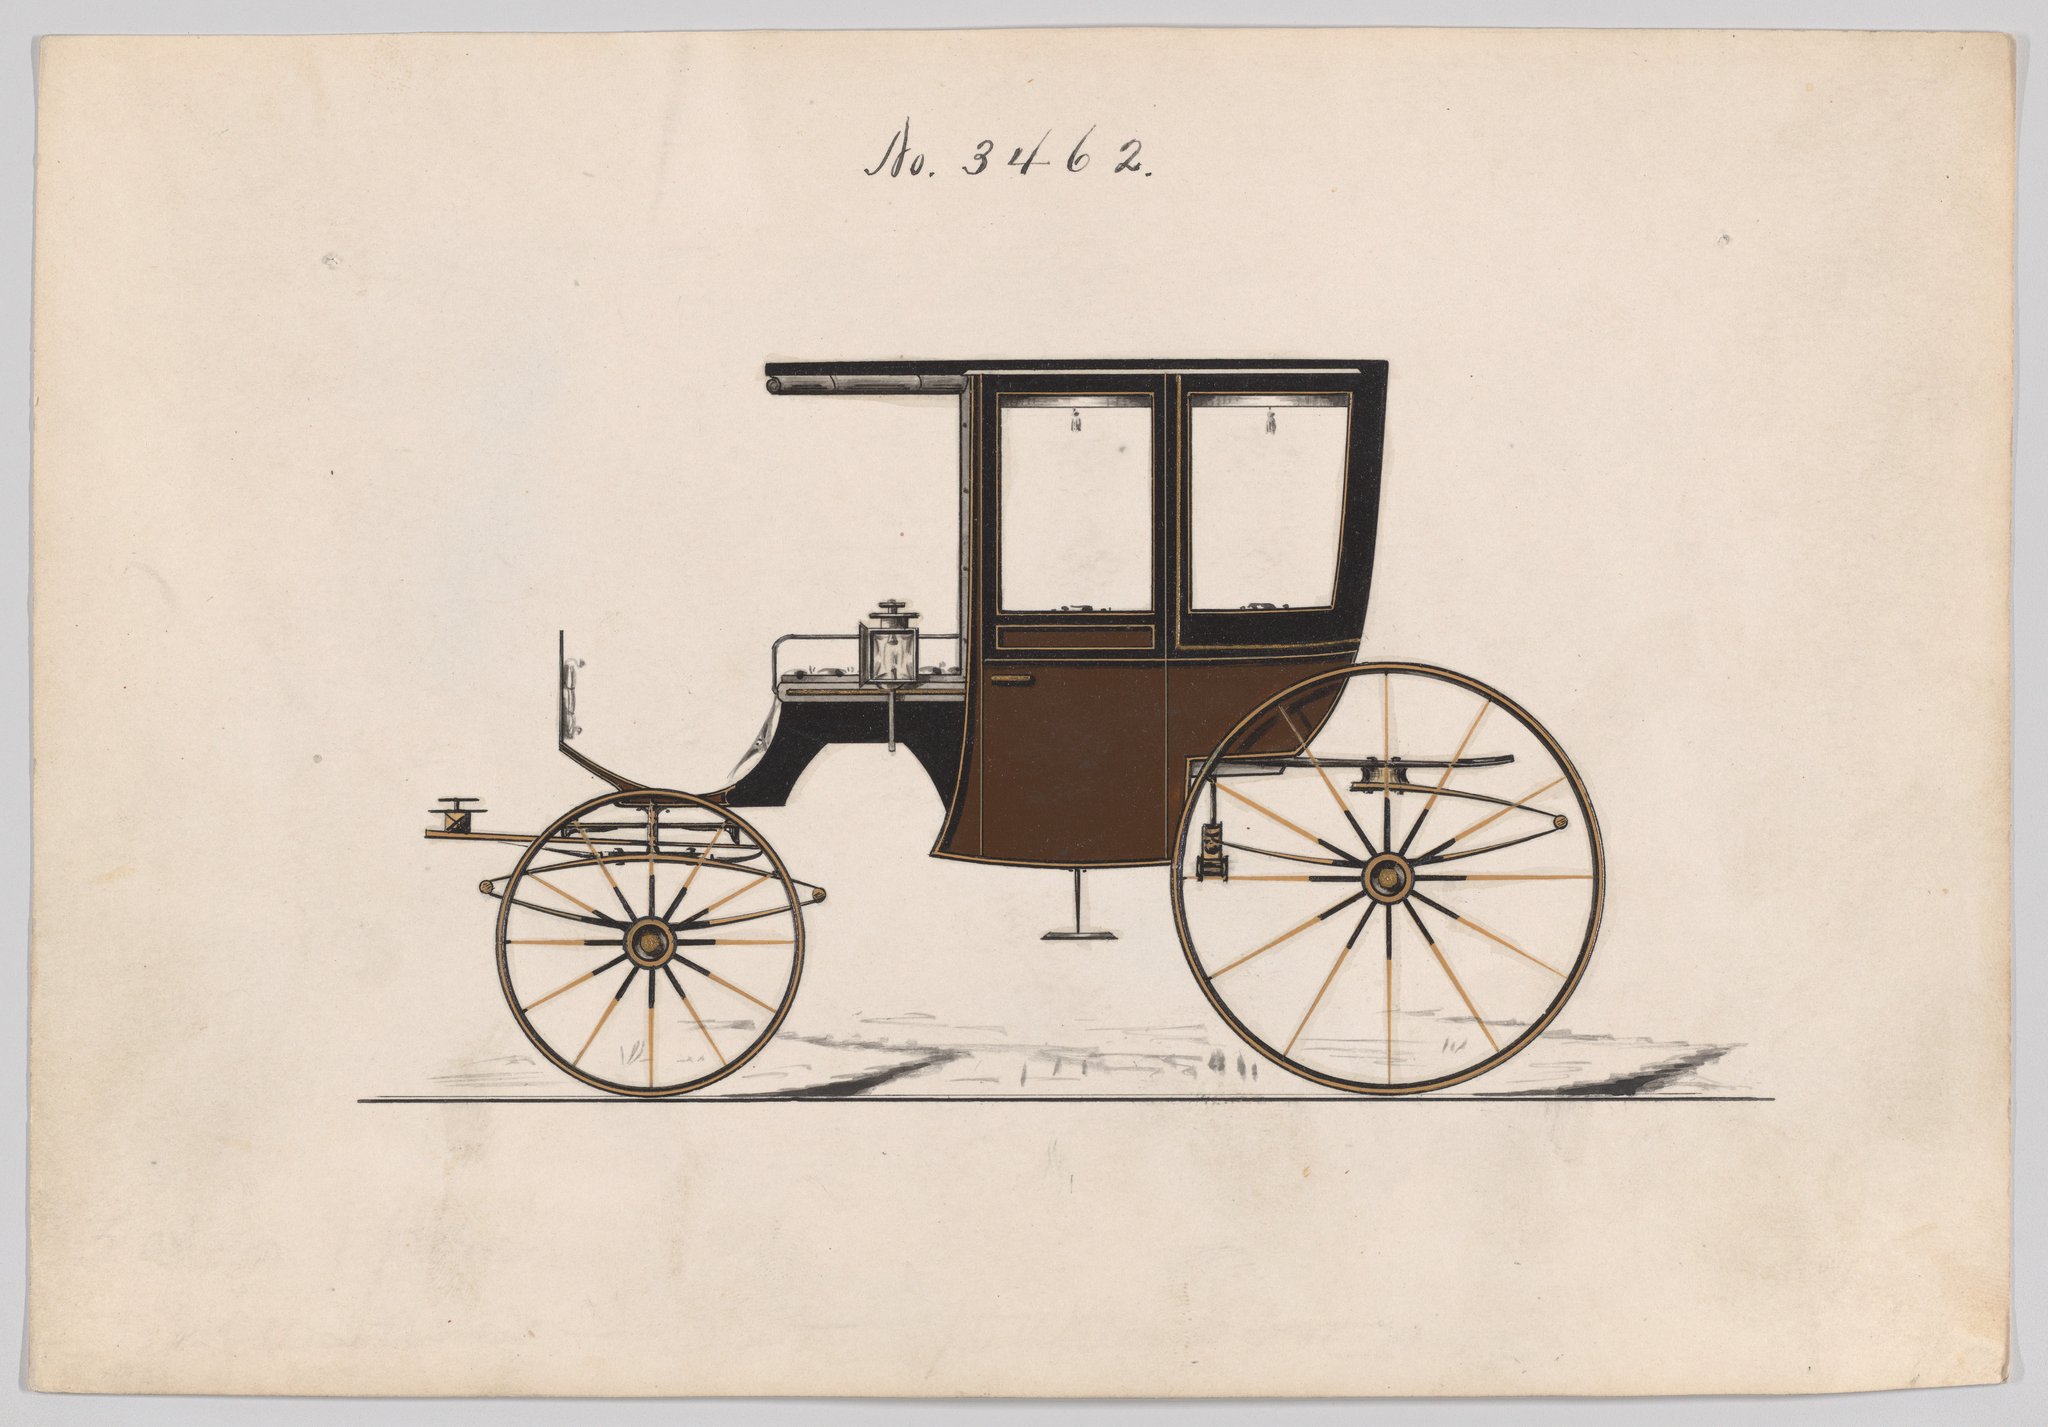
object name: drawing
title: Design for 4 seat Rockaway, no. 3462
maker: brewster & co.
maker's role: manufacturer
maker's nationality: american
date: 1878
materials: gouache, gum arabic, ink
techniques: pen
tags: carriages